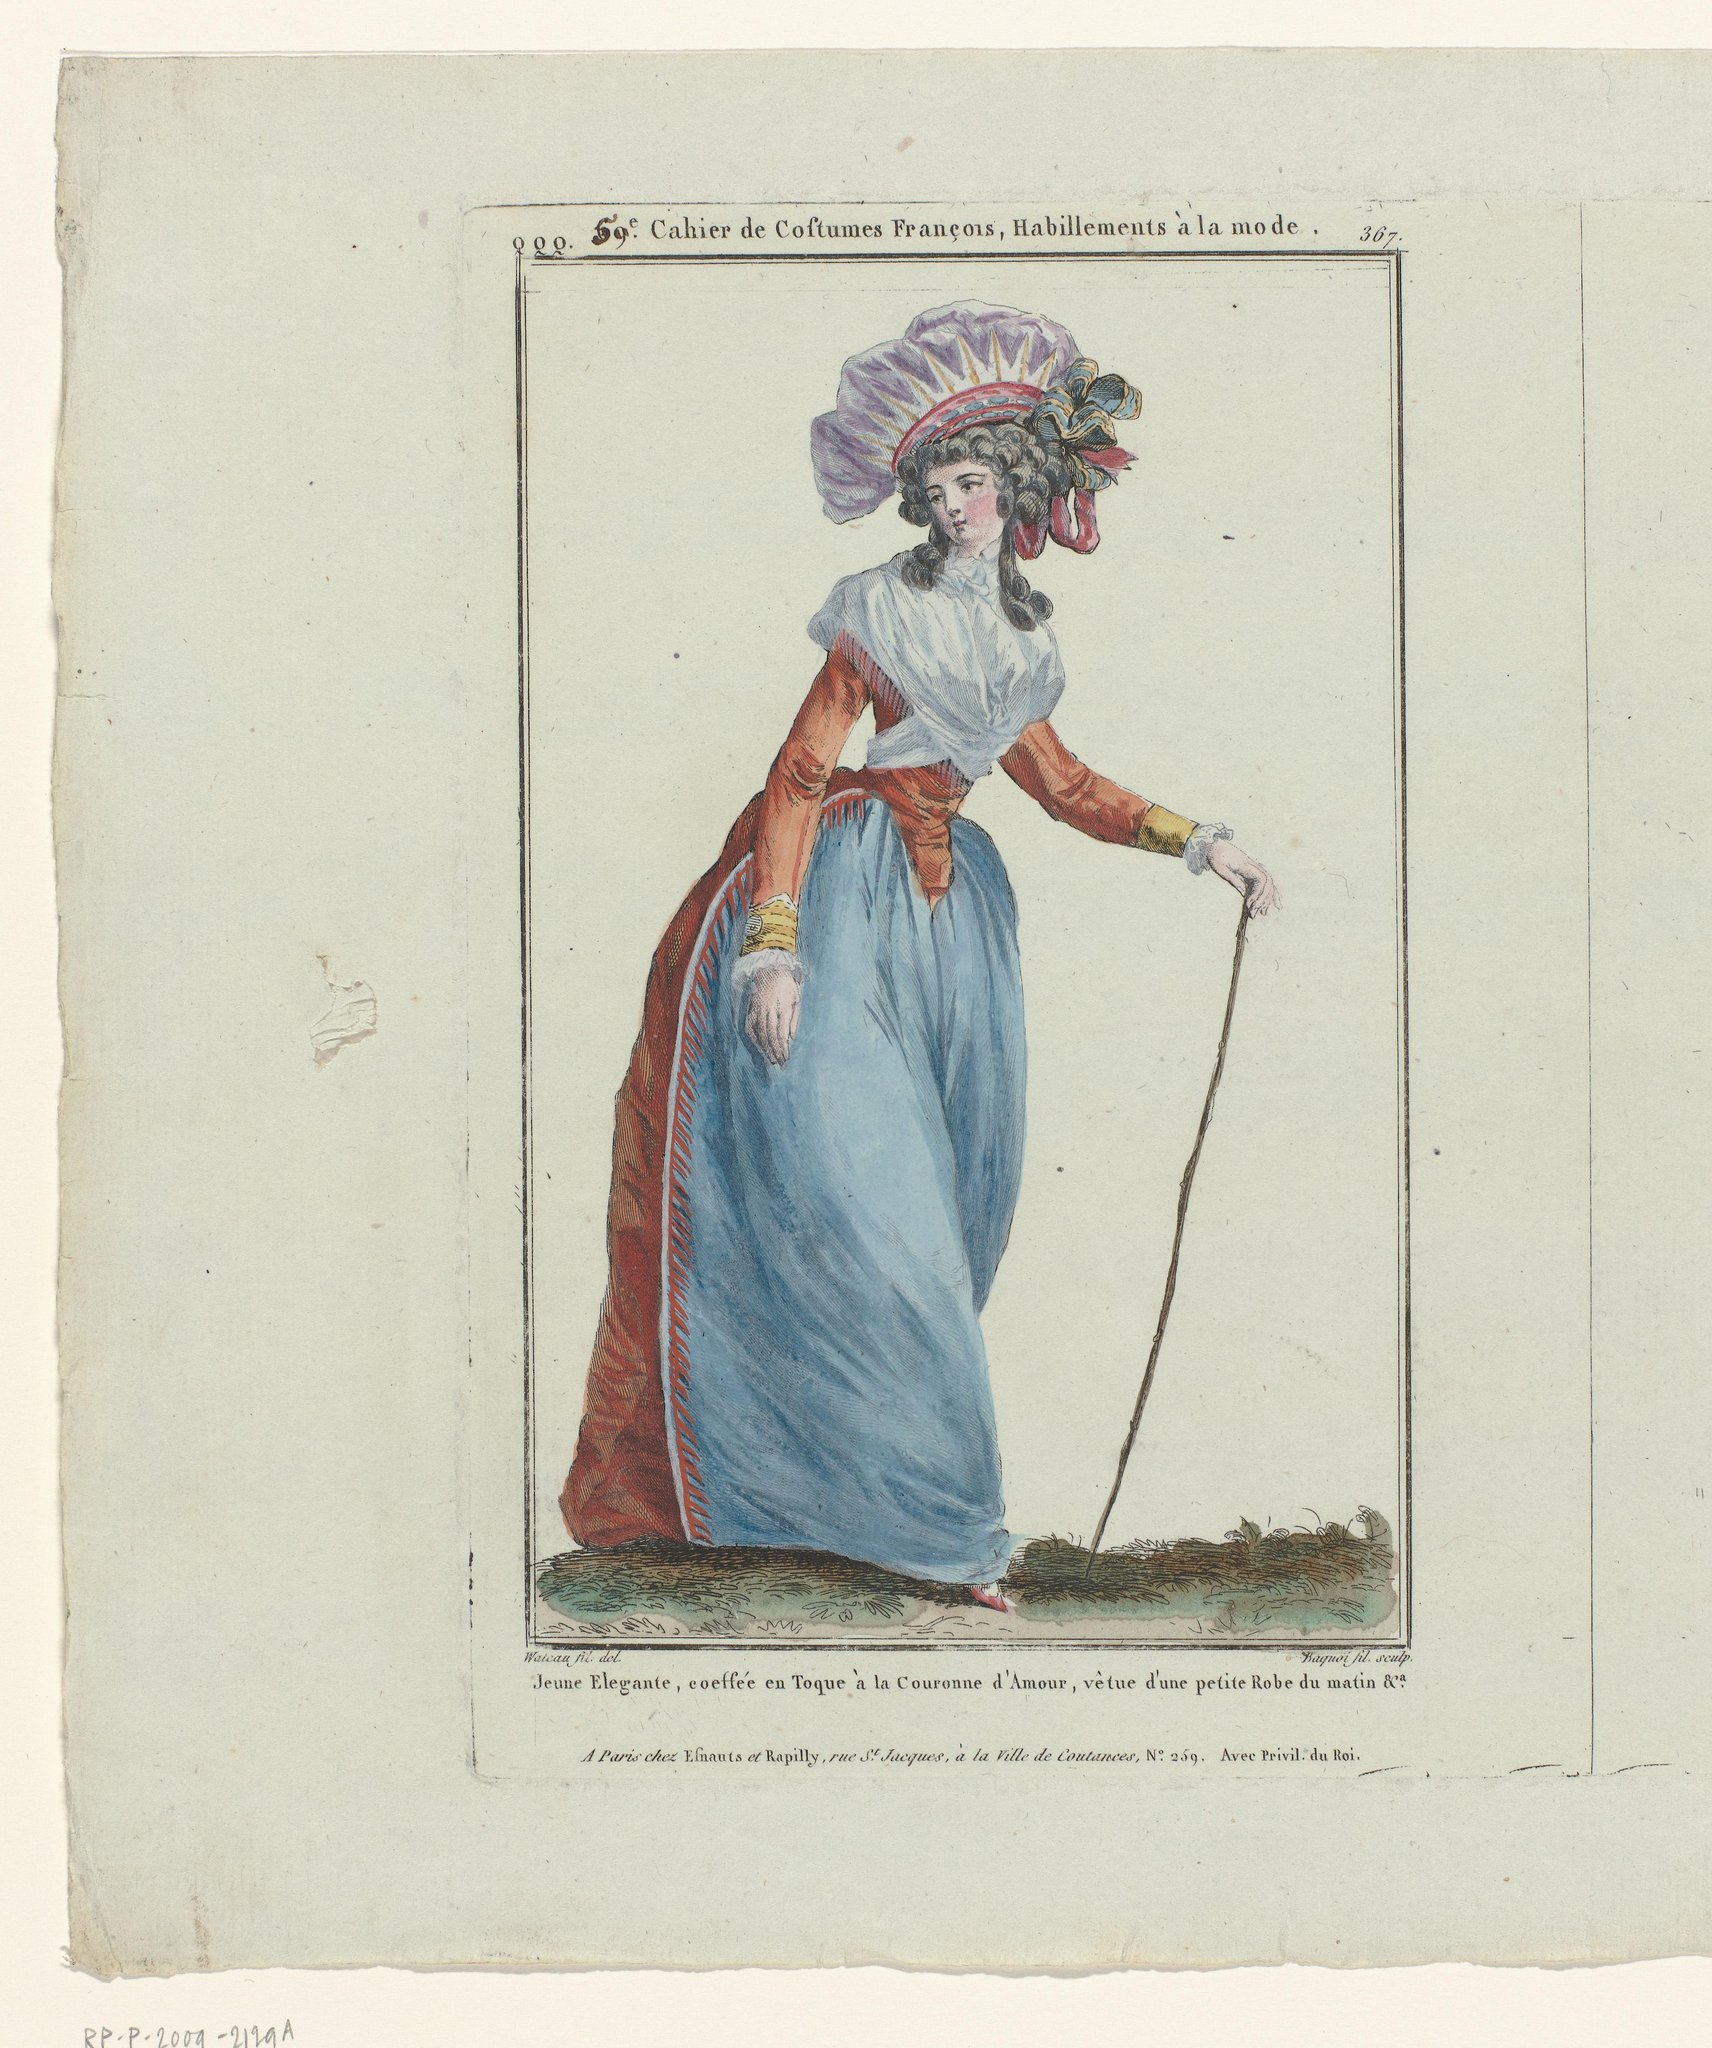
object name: fashion print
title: Gallerie des Modes et Costumes Français, 1787, qqq 367 : Jeune Elégante coeffé (...)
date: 1787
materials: paper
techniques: engraving, hand coloring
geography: paris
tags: head-gear: toque (+ women's clothes), walking-stick, staff, cane (+ women's clothes), dress, gown: morning dress (+ women's clothes), fashion plates, piece of clothing covering the breast or décolleté (fichu) (+ women's clothes)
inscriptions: caption: ‘Jeune Elégante coeffée en Toque à la Couronne d'Amour, vêtue d'une petite Robe du matin &a.’, title: ‘qqq. 59e Cahier de Costumes Françaois, Habillements à la mode. 367’, address: ‘A Paris chez Esnauts et Rapilly, rue St. Jacques, à la Ville de Coutances, No. 259. Avec Privil. du Roi.’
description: Jonge elegante vrouw gekleed in een ochtendjapon. Op het hoofd een 'toque à la Couronne d'Amour'. Fichu. Wandelstok. Uit de serie qqq. 69e (pour 59) cahier de costumes français, habillemens à la mode, Gallerie des Modes et Costumes Français. Twee afbeeldingen op één plaat gedrukt, zie ook qqq. 368.